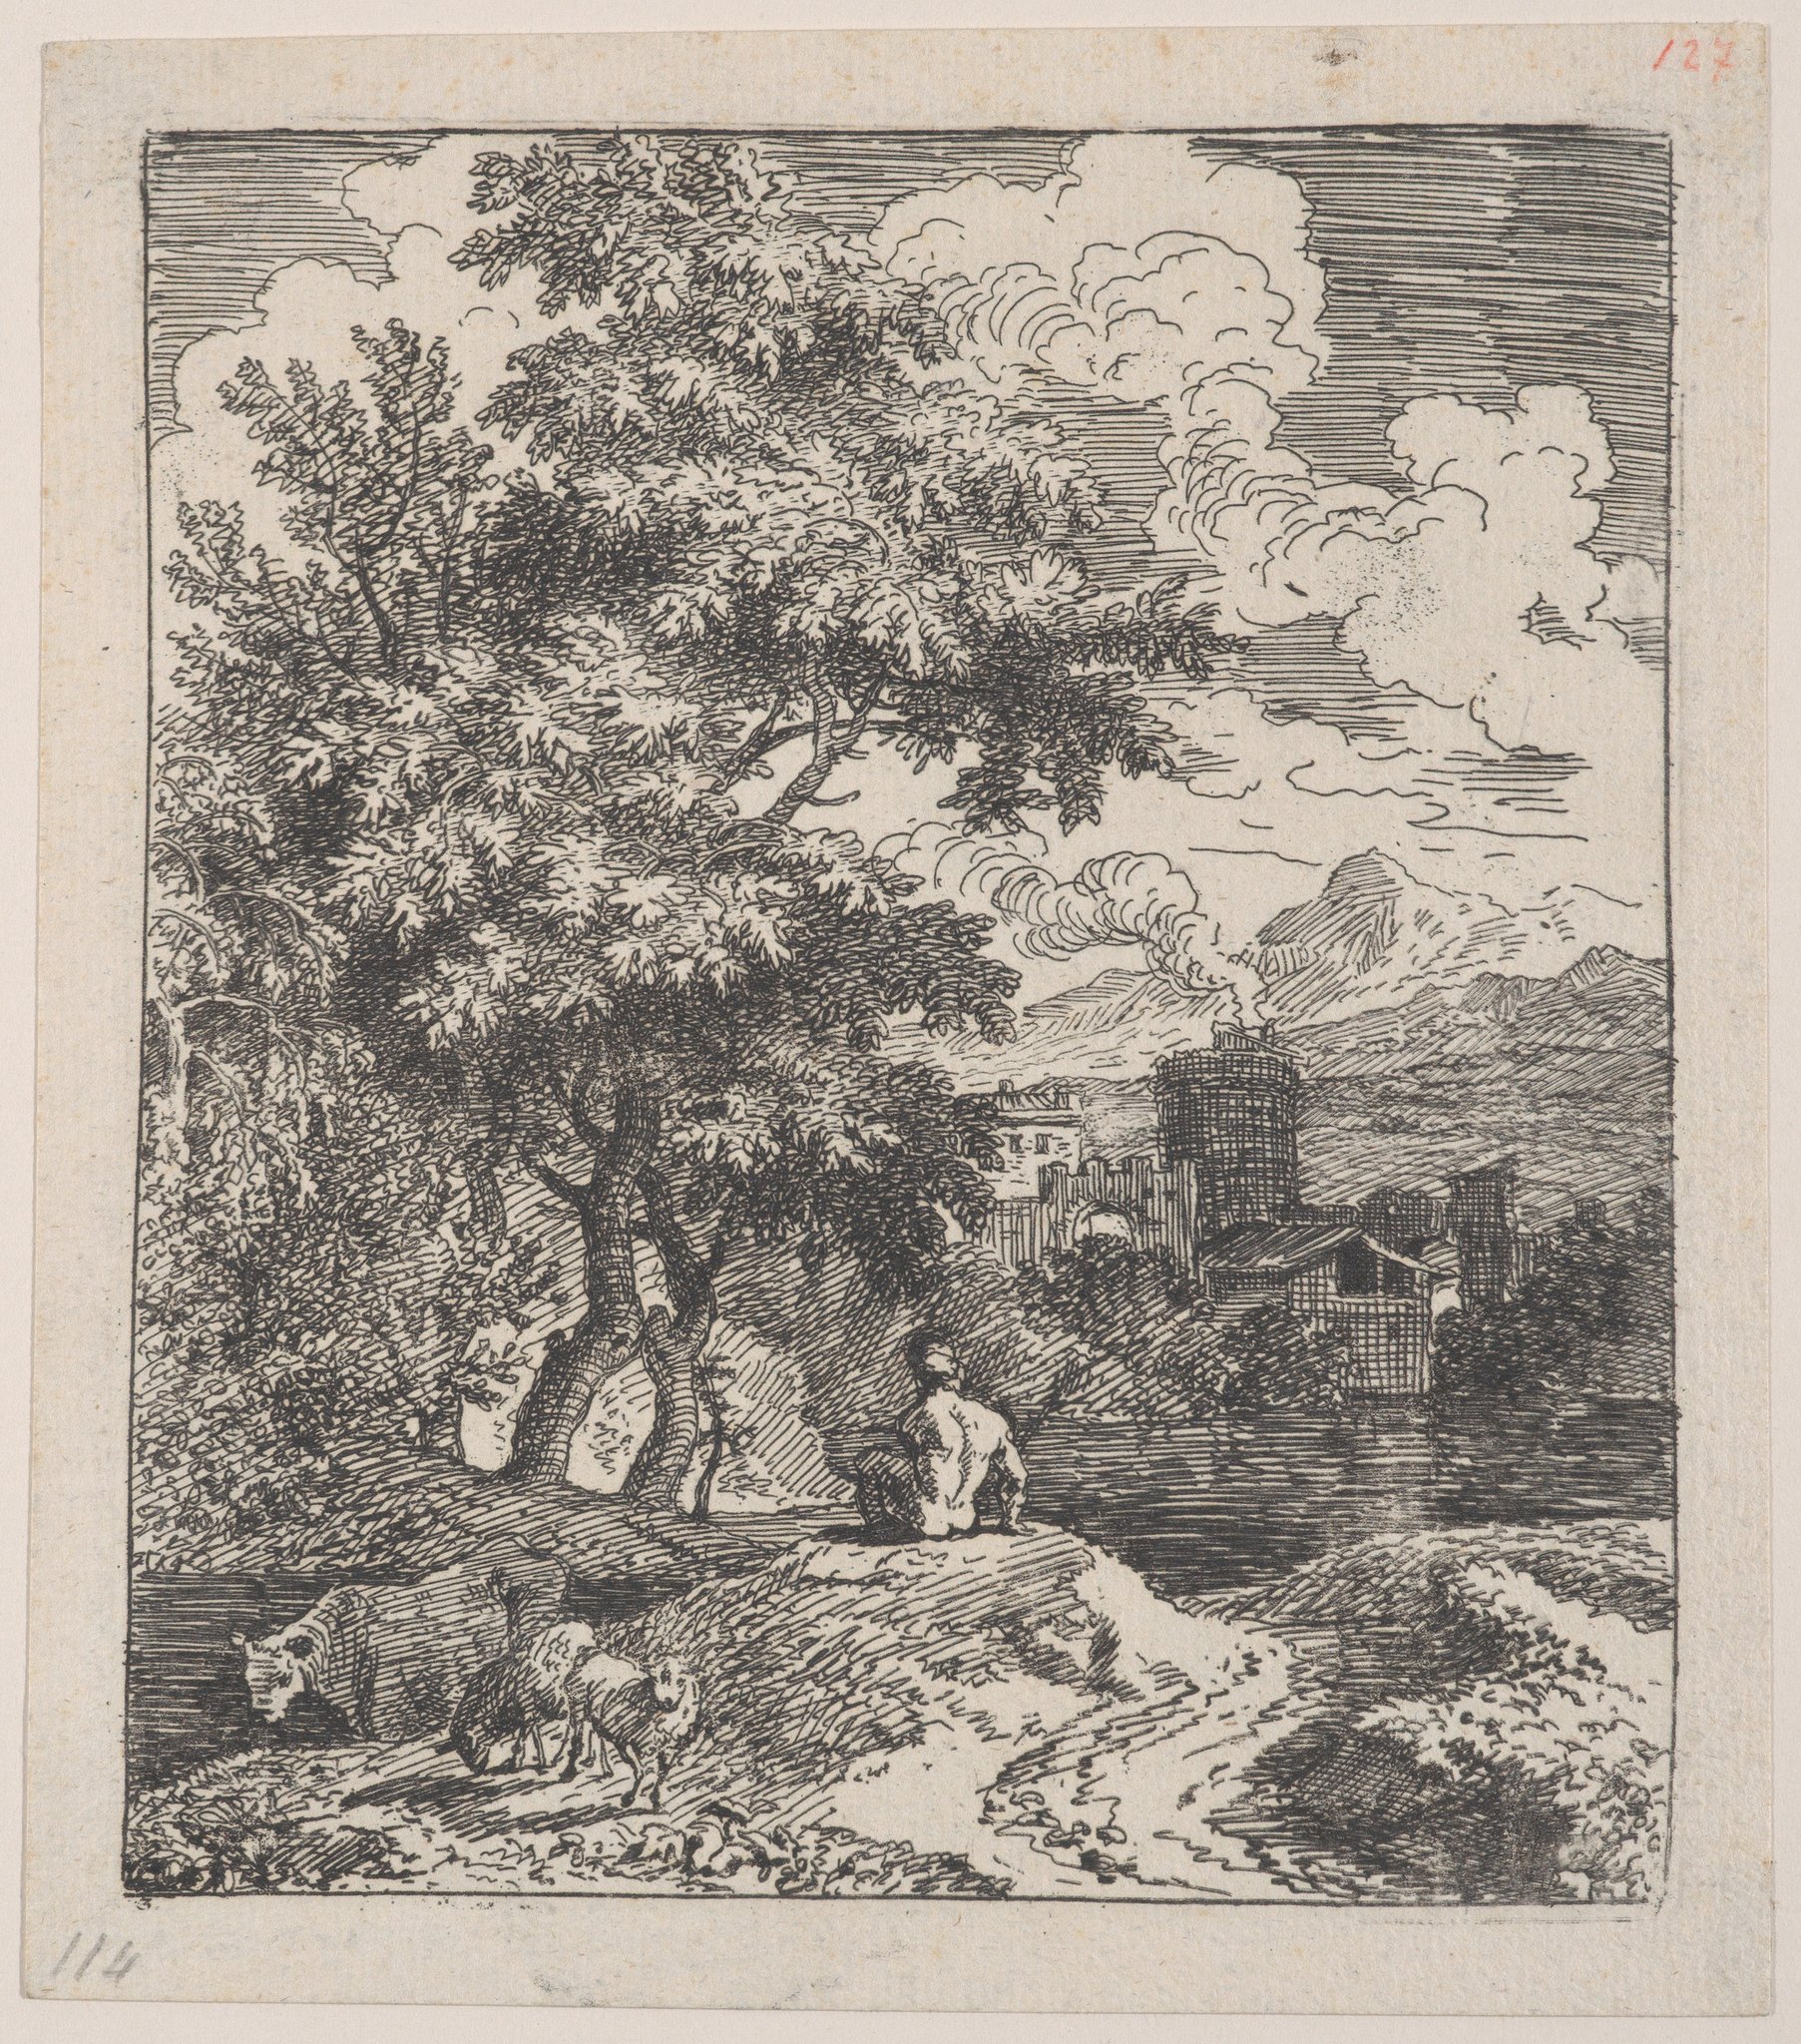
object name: print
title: Plate 3: a shepherd seated on a hill, a cow and two sheep at left, and a town in right background, from 'Landscapes in the manner of Gaspar Dughet'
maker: franz joachim beich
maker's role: artist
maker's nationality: german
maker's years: 1665-1745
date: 1700-1725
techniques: etching